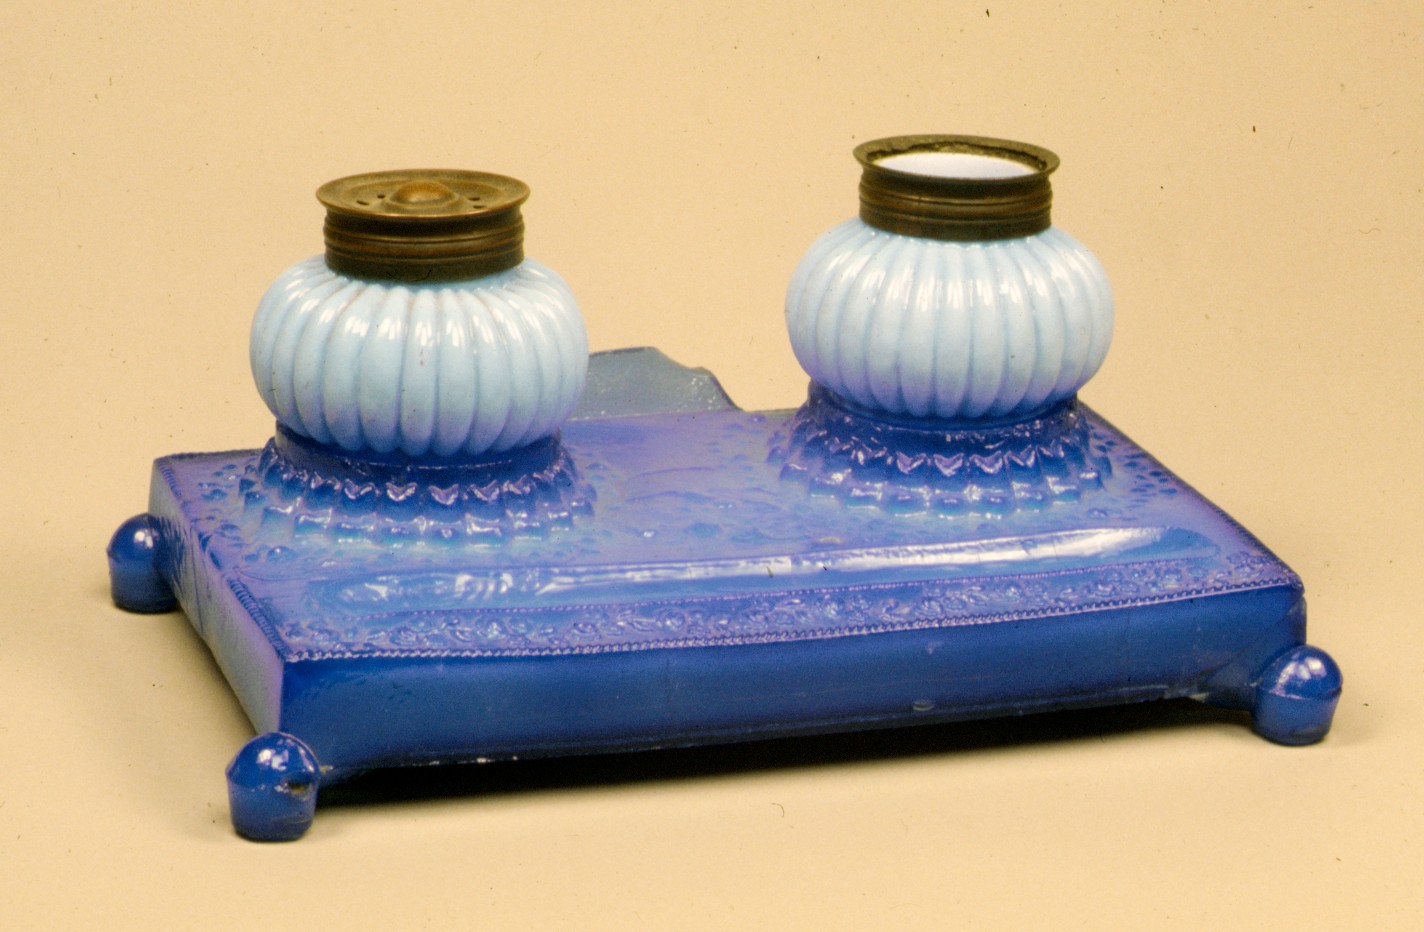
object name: inkstand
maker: boston & sandwich glass company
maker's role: manufacturer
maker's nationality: american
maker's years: 1825-1888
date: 1830-1840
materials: glass, pewter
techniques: glassblowing, molding, pressed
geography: united states